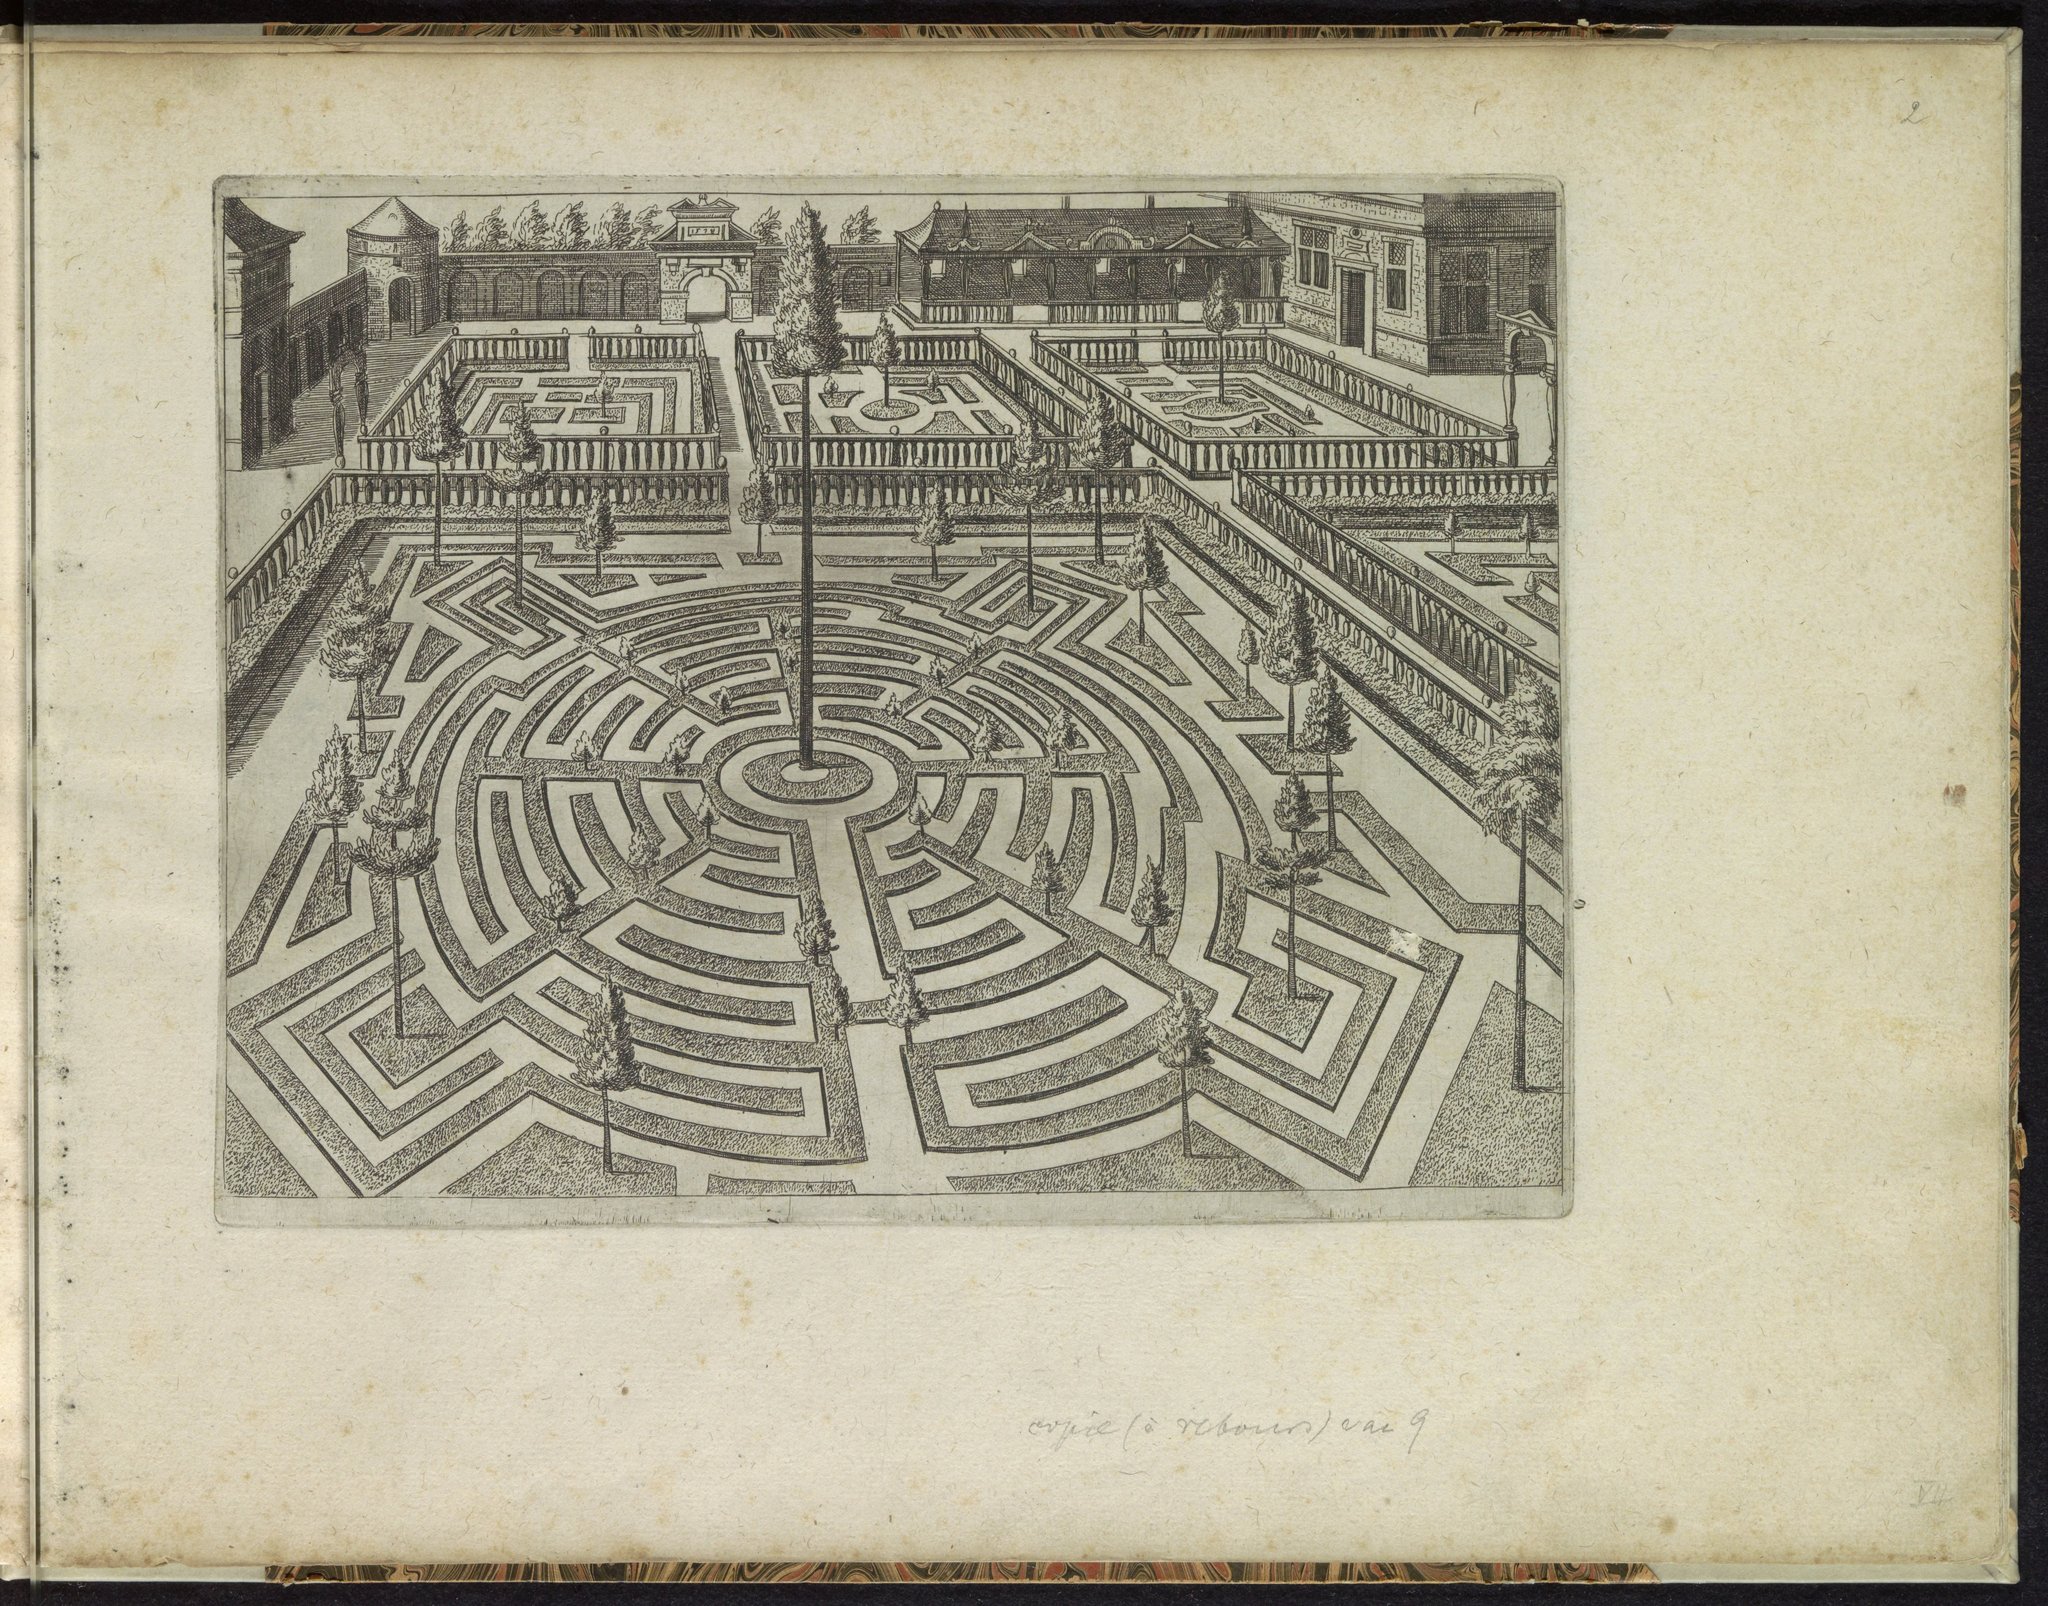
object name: album leaf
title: Tuinen (8-bladige reeks)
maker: johann bussemacher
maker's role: print maker, printer, publisher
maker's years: -1627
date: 1615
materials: paper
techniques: etching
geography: cologne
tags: garden, labyrinth, maze ~ garden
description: Tuin met ronde parterre, omgeven door een balustrade. Ernaast liggen vier met balustrades omgeven perken. De prent maakt deel uit van een album.